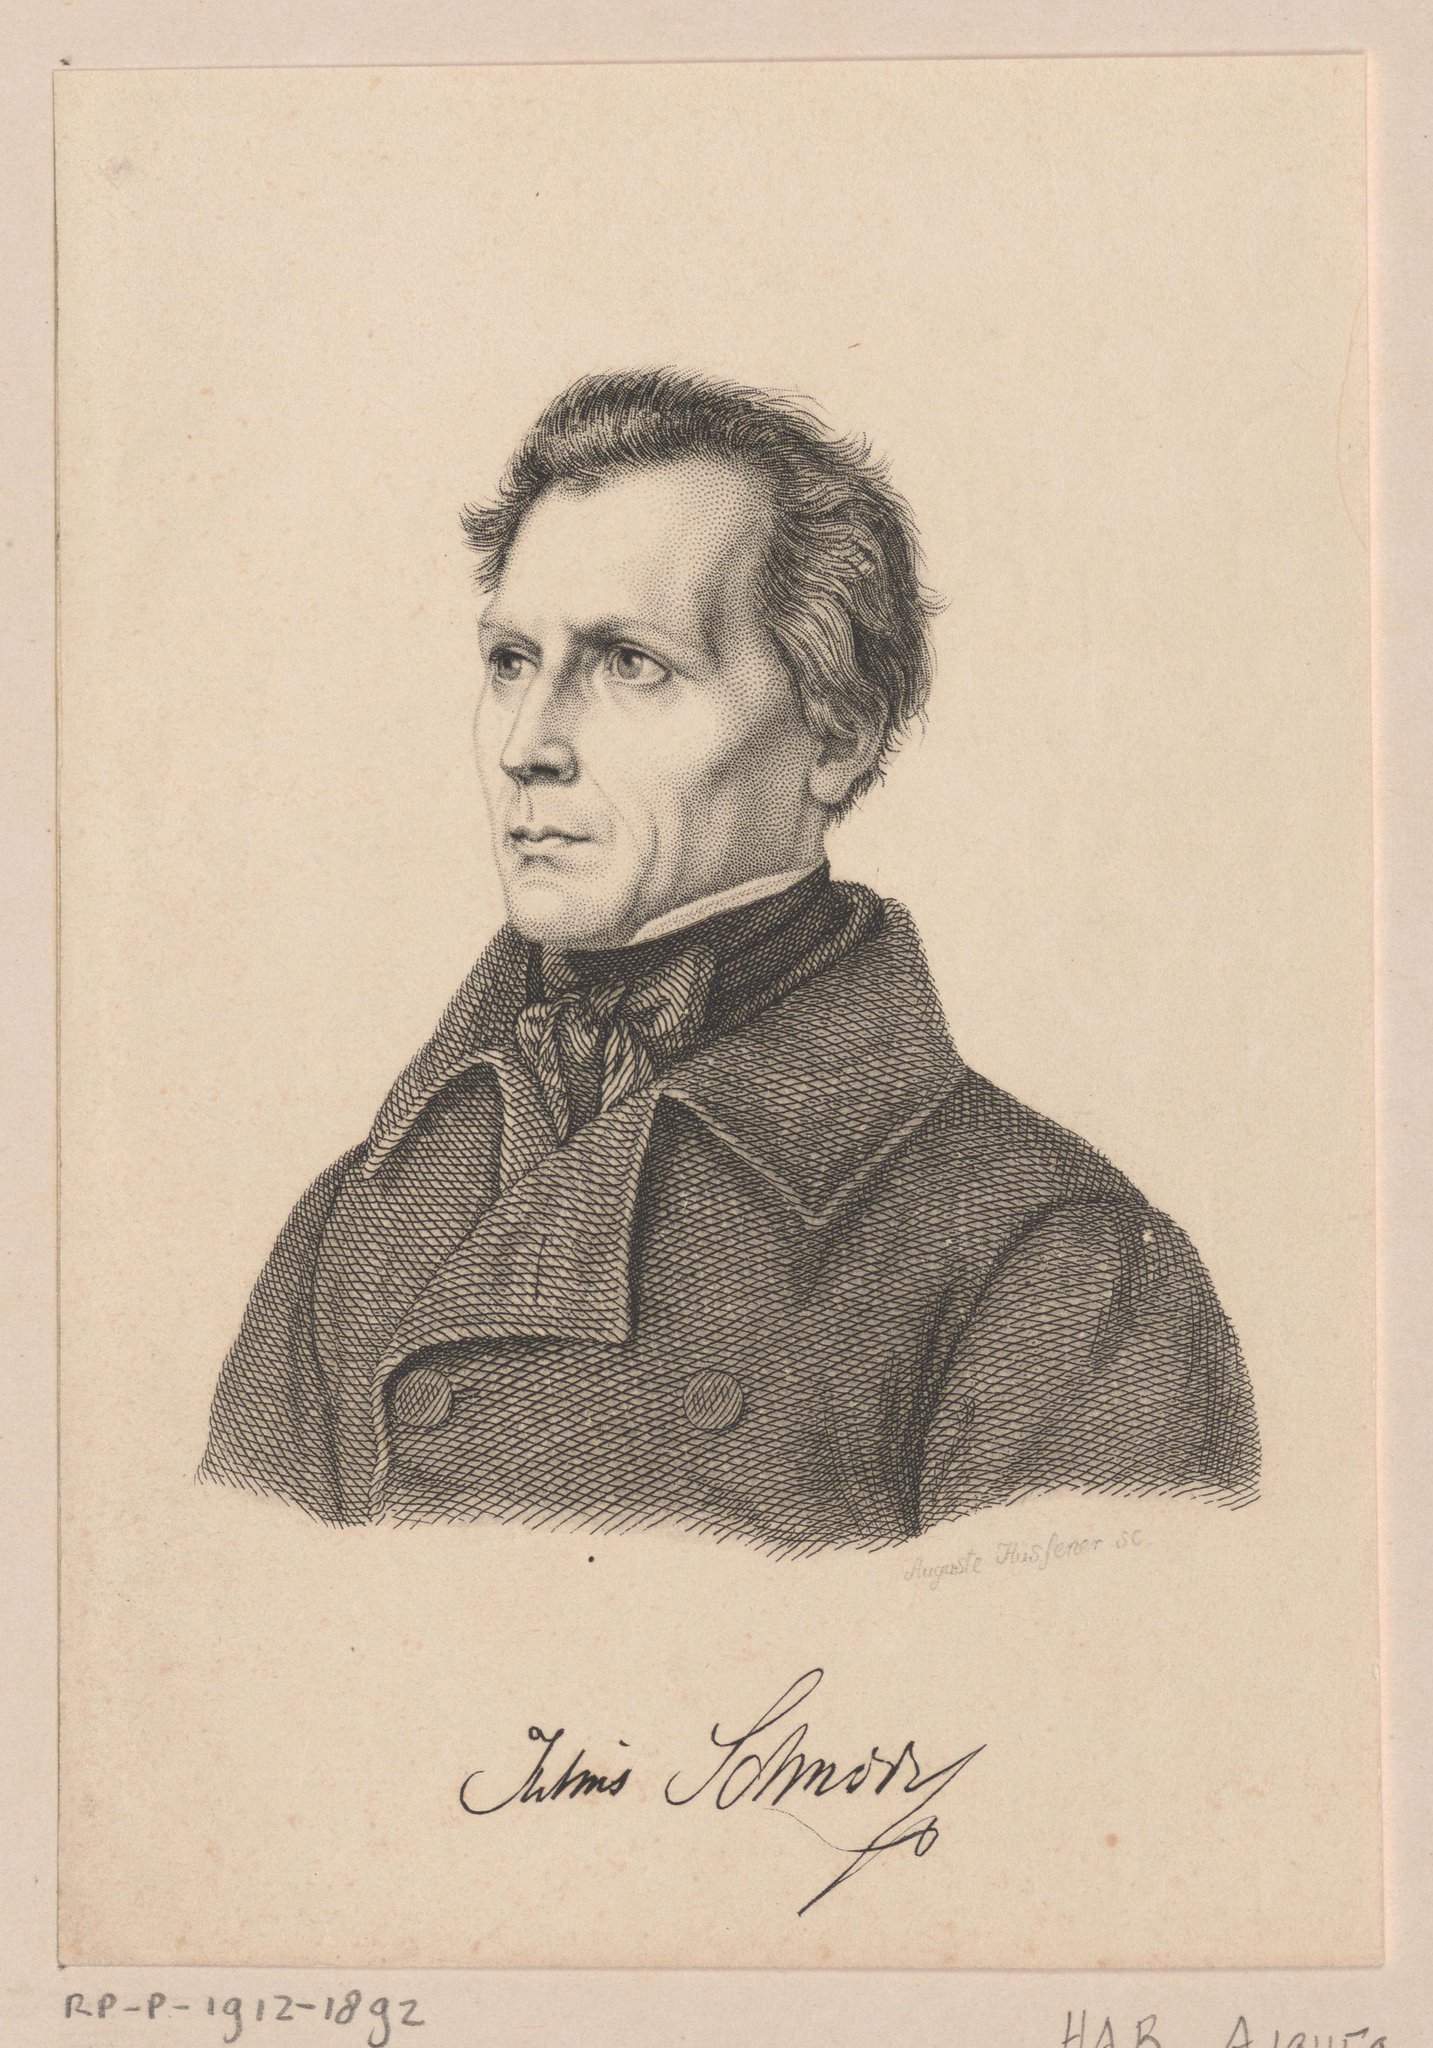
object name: print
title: Portret van Julius Schnorr von Carolsfeld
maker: auguste hüssener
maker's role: print maker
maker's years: 1789-1877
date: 1811-1877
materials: paper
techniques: etching, intaglio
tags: draughtsman, julius schnorr von carolsfeld, historical persons, portrait, self-portrait of artist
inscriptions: collector's mark: Lugt 2228